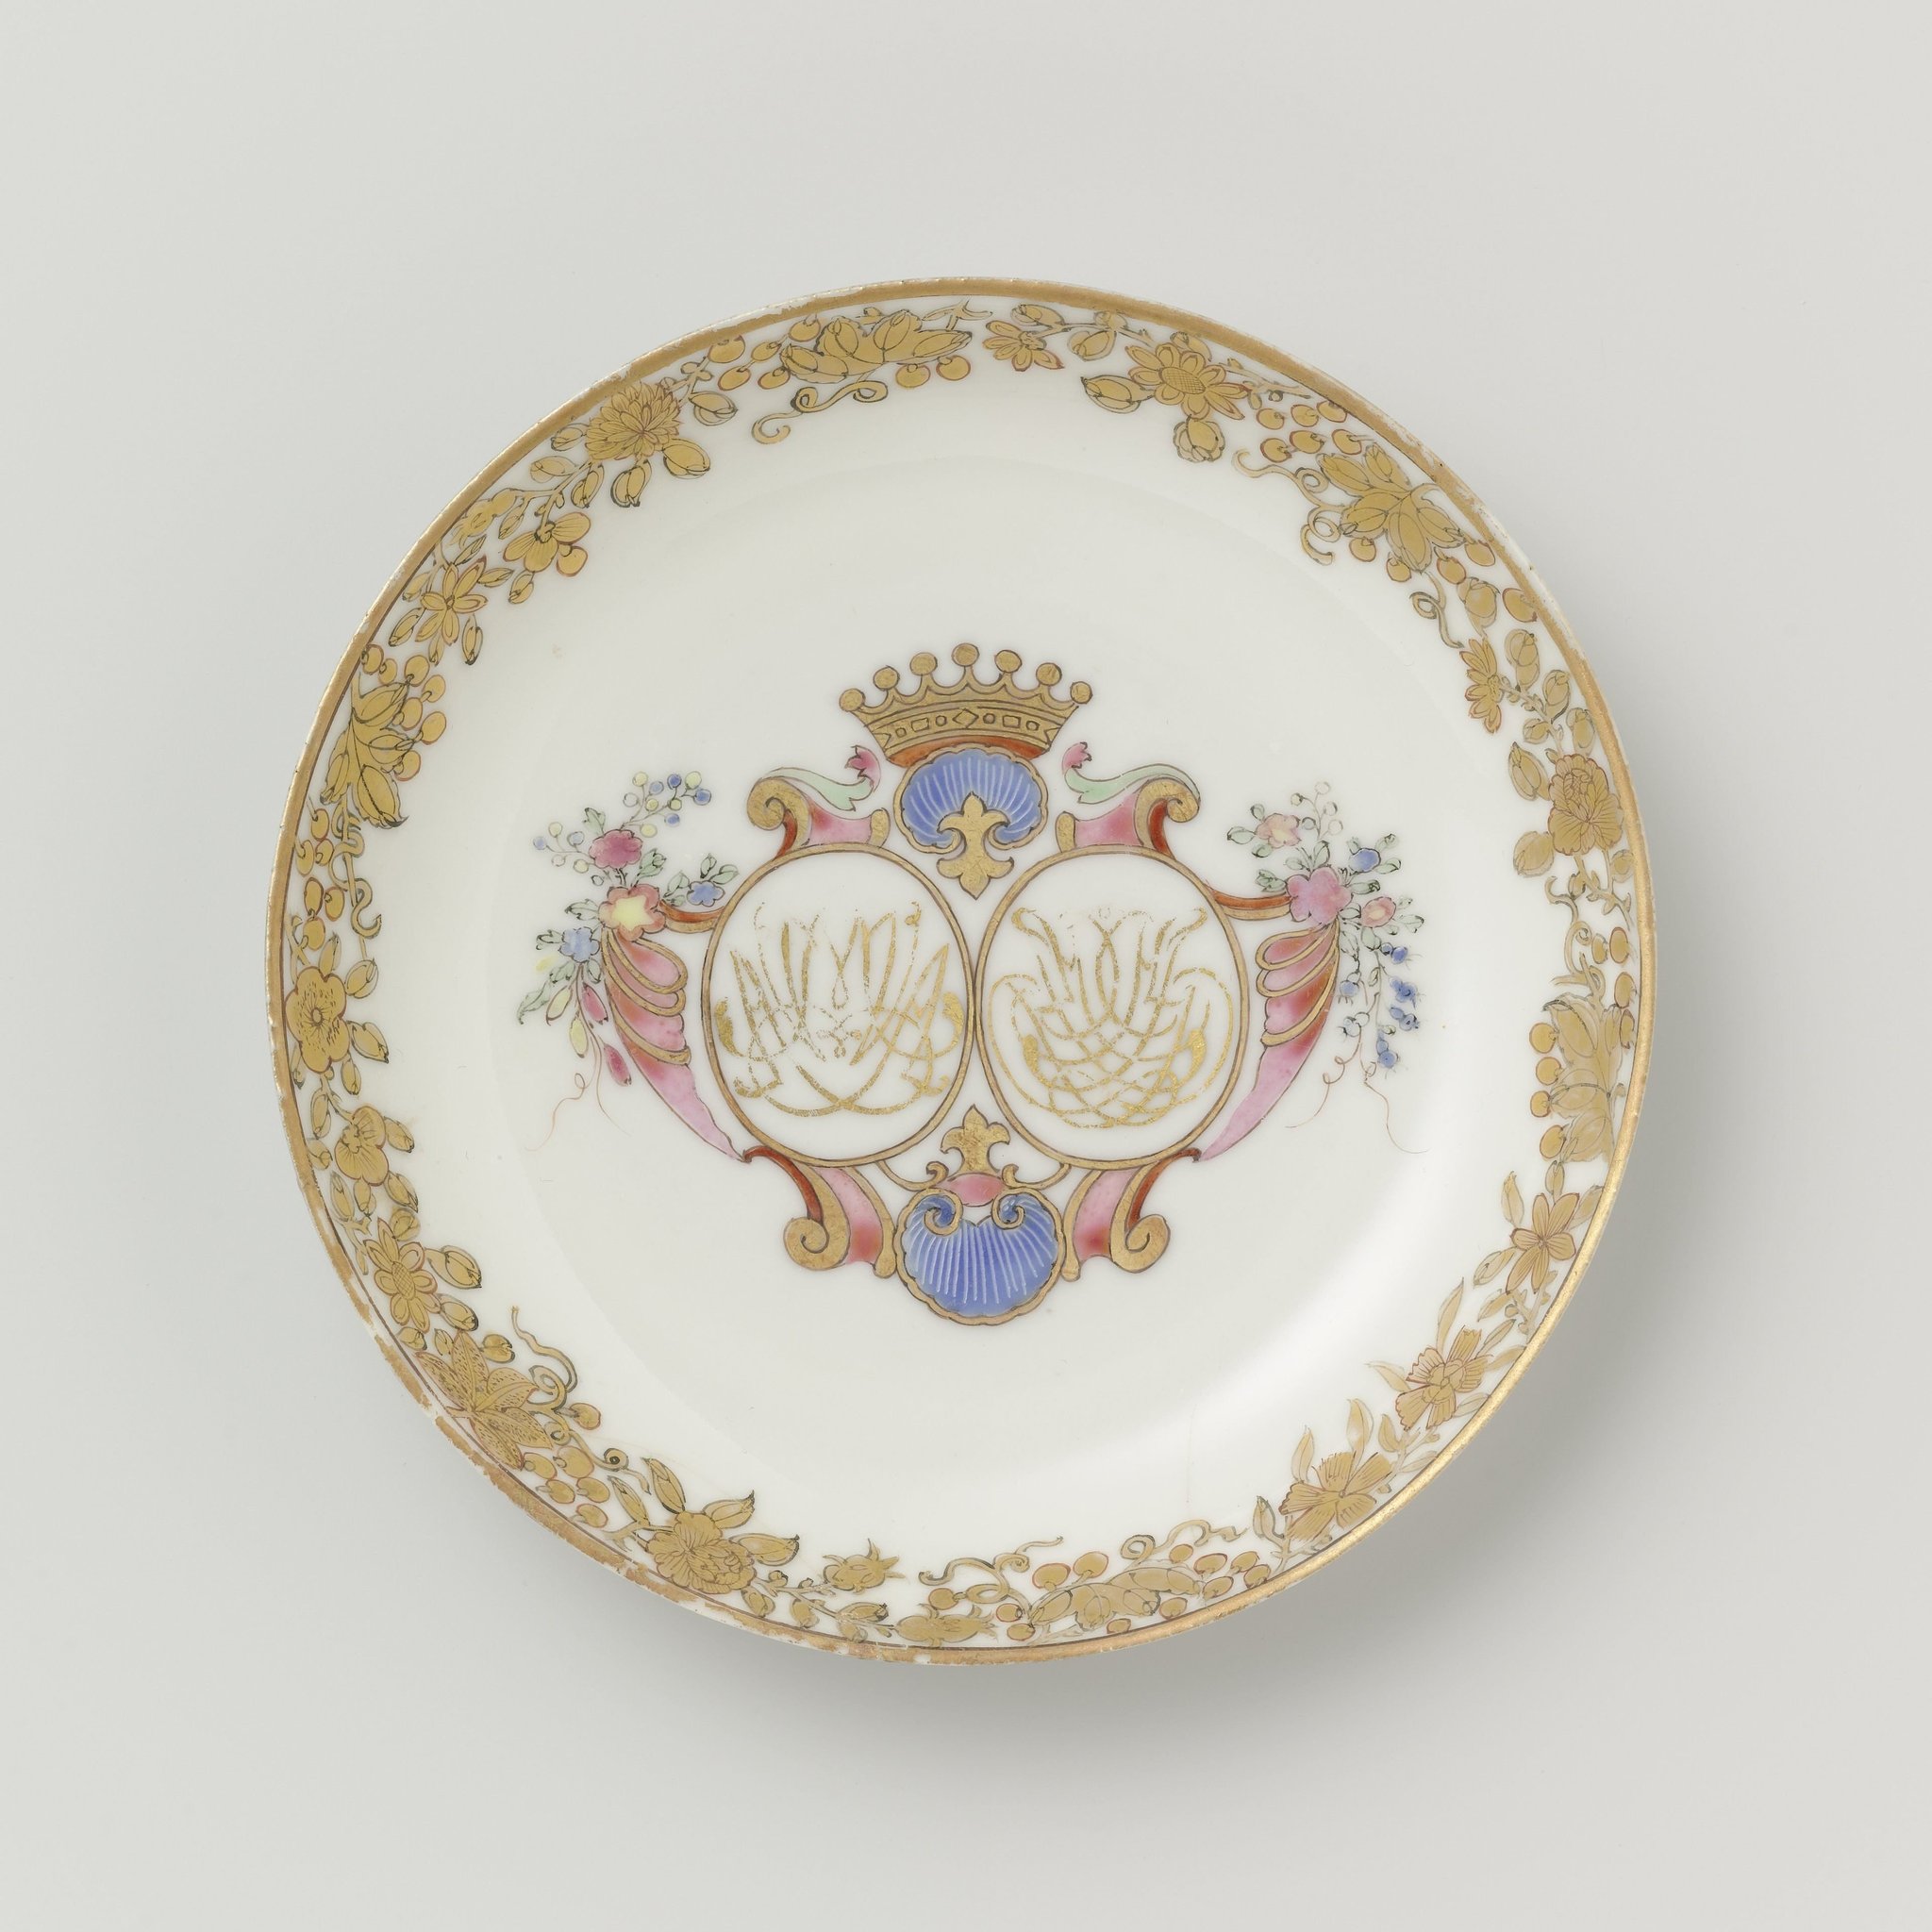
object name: platter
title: Saucer from the 'Swellengrebel service' with a double crowned monogram and a border with floral scrolls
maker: Anonymous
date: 1740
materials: glaze, gold, paint, porcelain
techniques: firing, gilding, turning, vitrification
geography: china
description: De monogrammen 'MVA' en 'CHTD' staan voor Maurits van Aerden (1694-1746) en Constantia Helena ten Damme (1694-1772), getrouwd in 1716. Het servies is waarschijnlijk besteld ter ere van hun vijfentwingtigjarig huwelijksjubileum in 1741. (Campen, Jan van & Hartkamp-Jonxis, Ebeltje, Aziatische weelde : VOC-kunst in het Rijksmuseum, Zutphen 2011, p. 78)